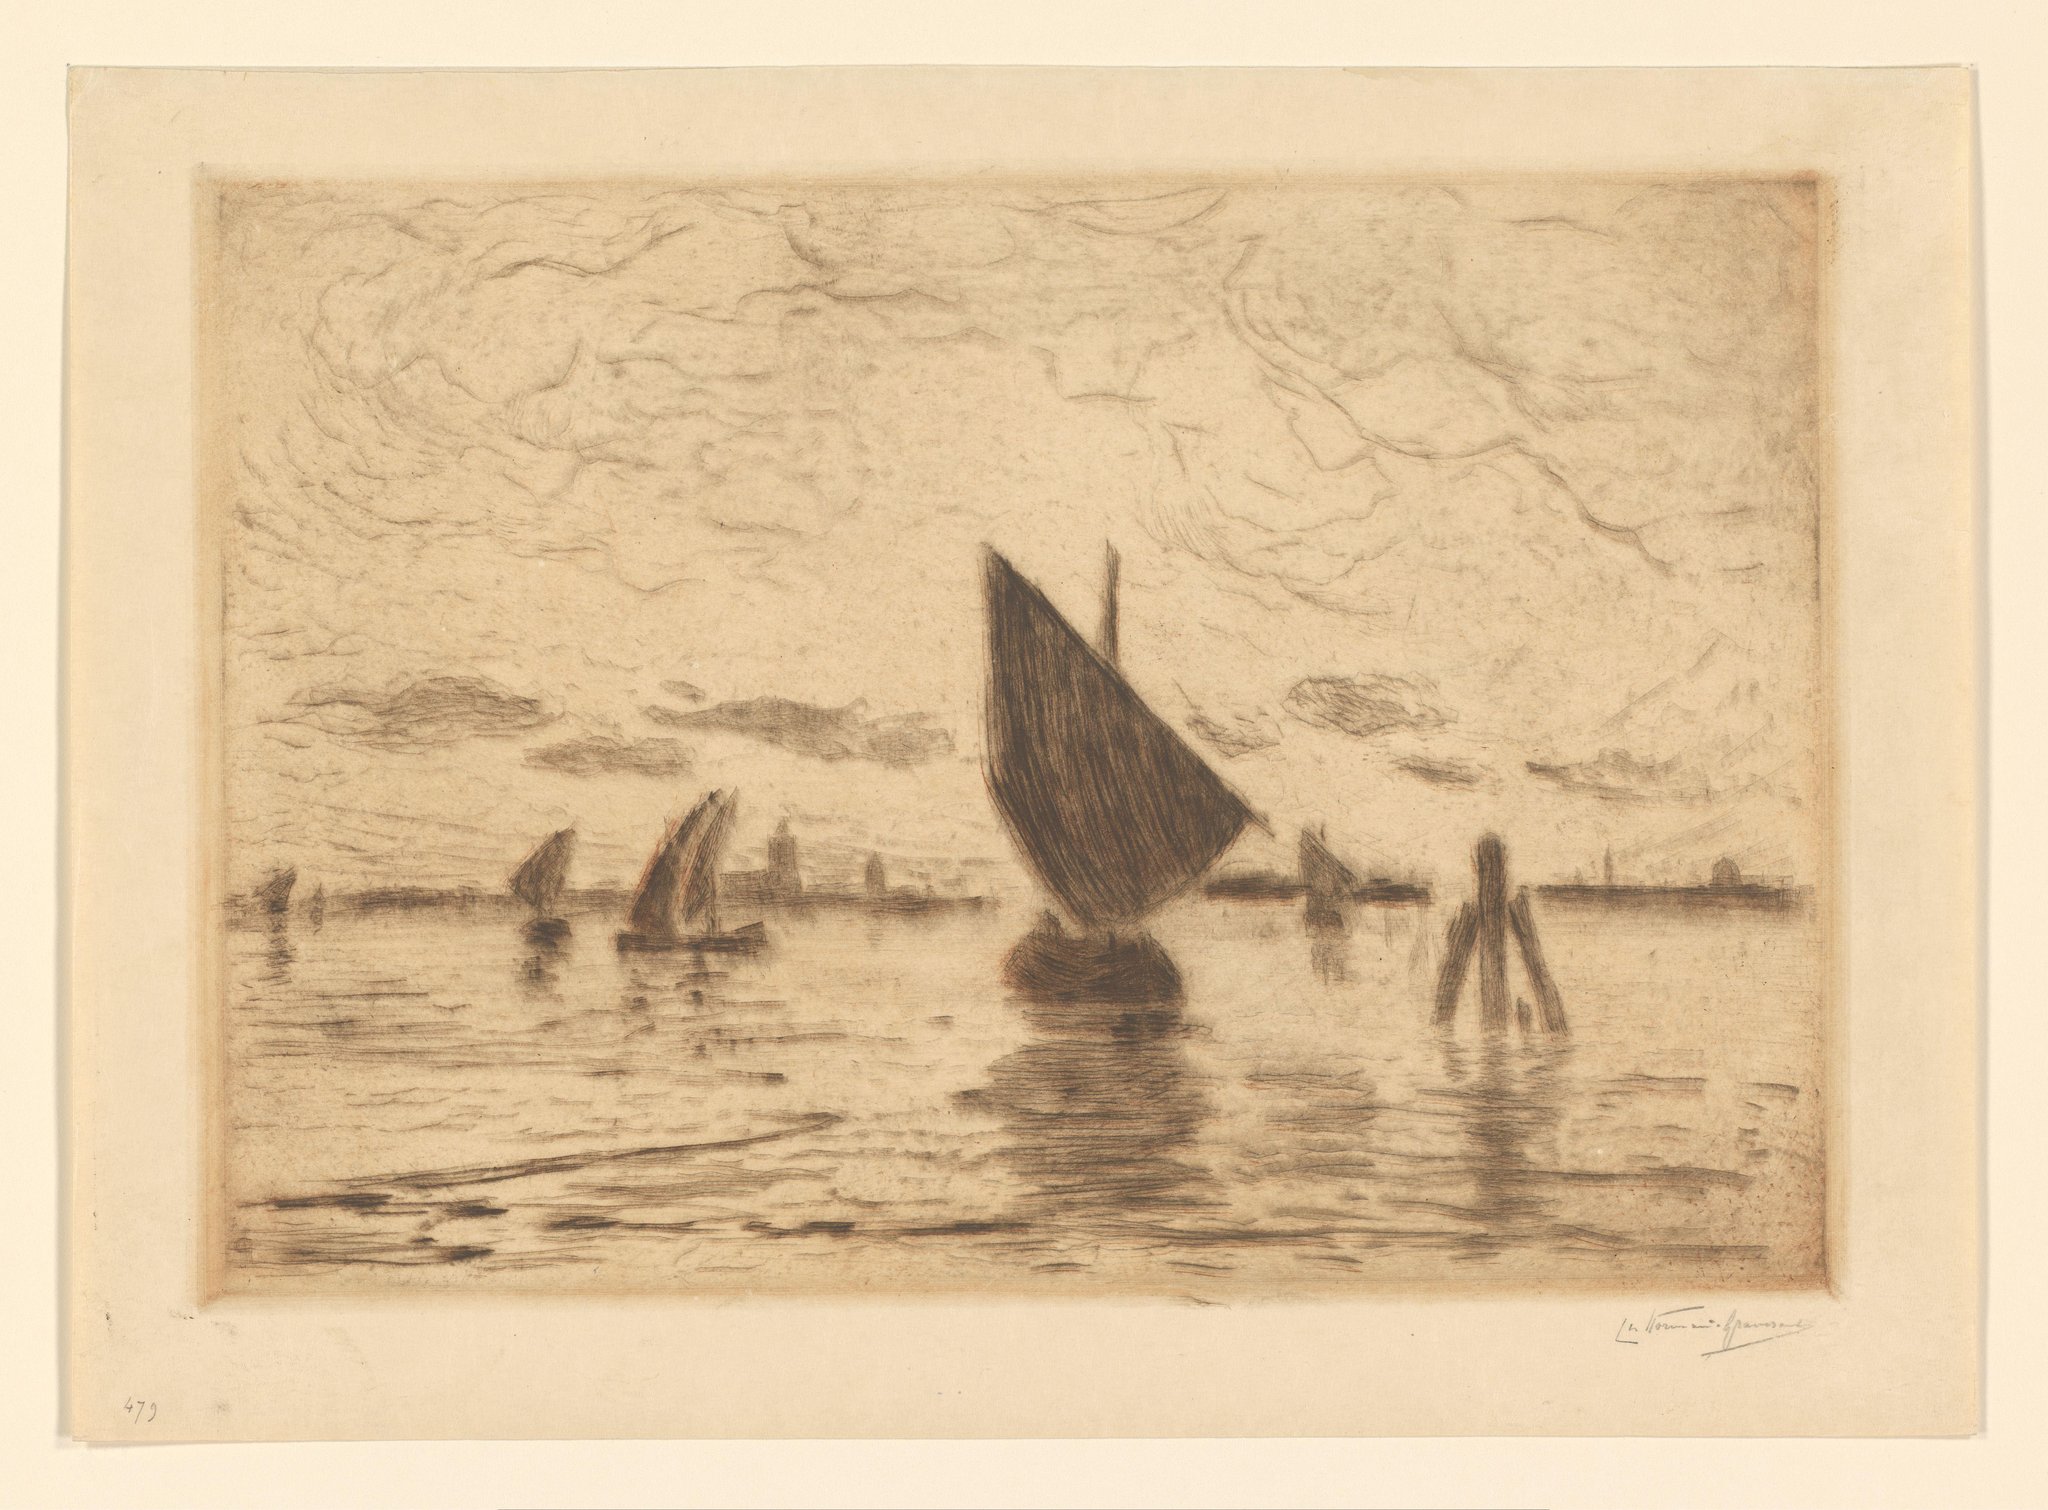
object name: print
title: Zeilboten op het water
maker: carel nicolaas storm van s-gravesande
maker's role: draughtsman, print maker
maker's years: 1841-1924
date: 1851-1924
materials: paper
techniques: drypoint, intaglio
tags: sailing-ship, sailing-boat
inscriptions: collector's mark: Lugt 2228